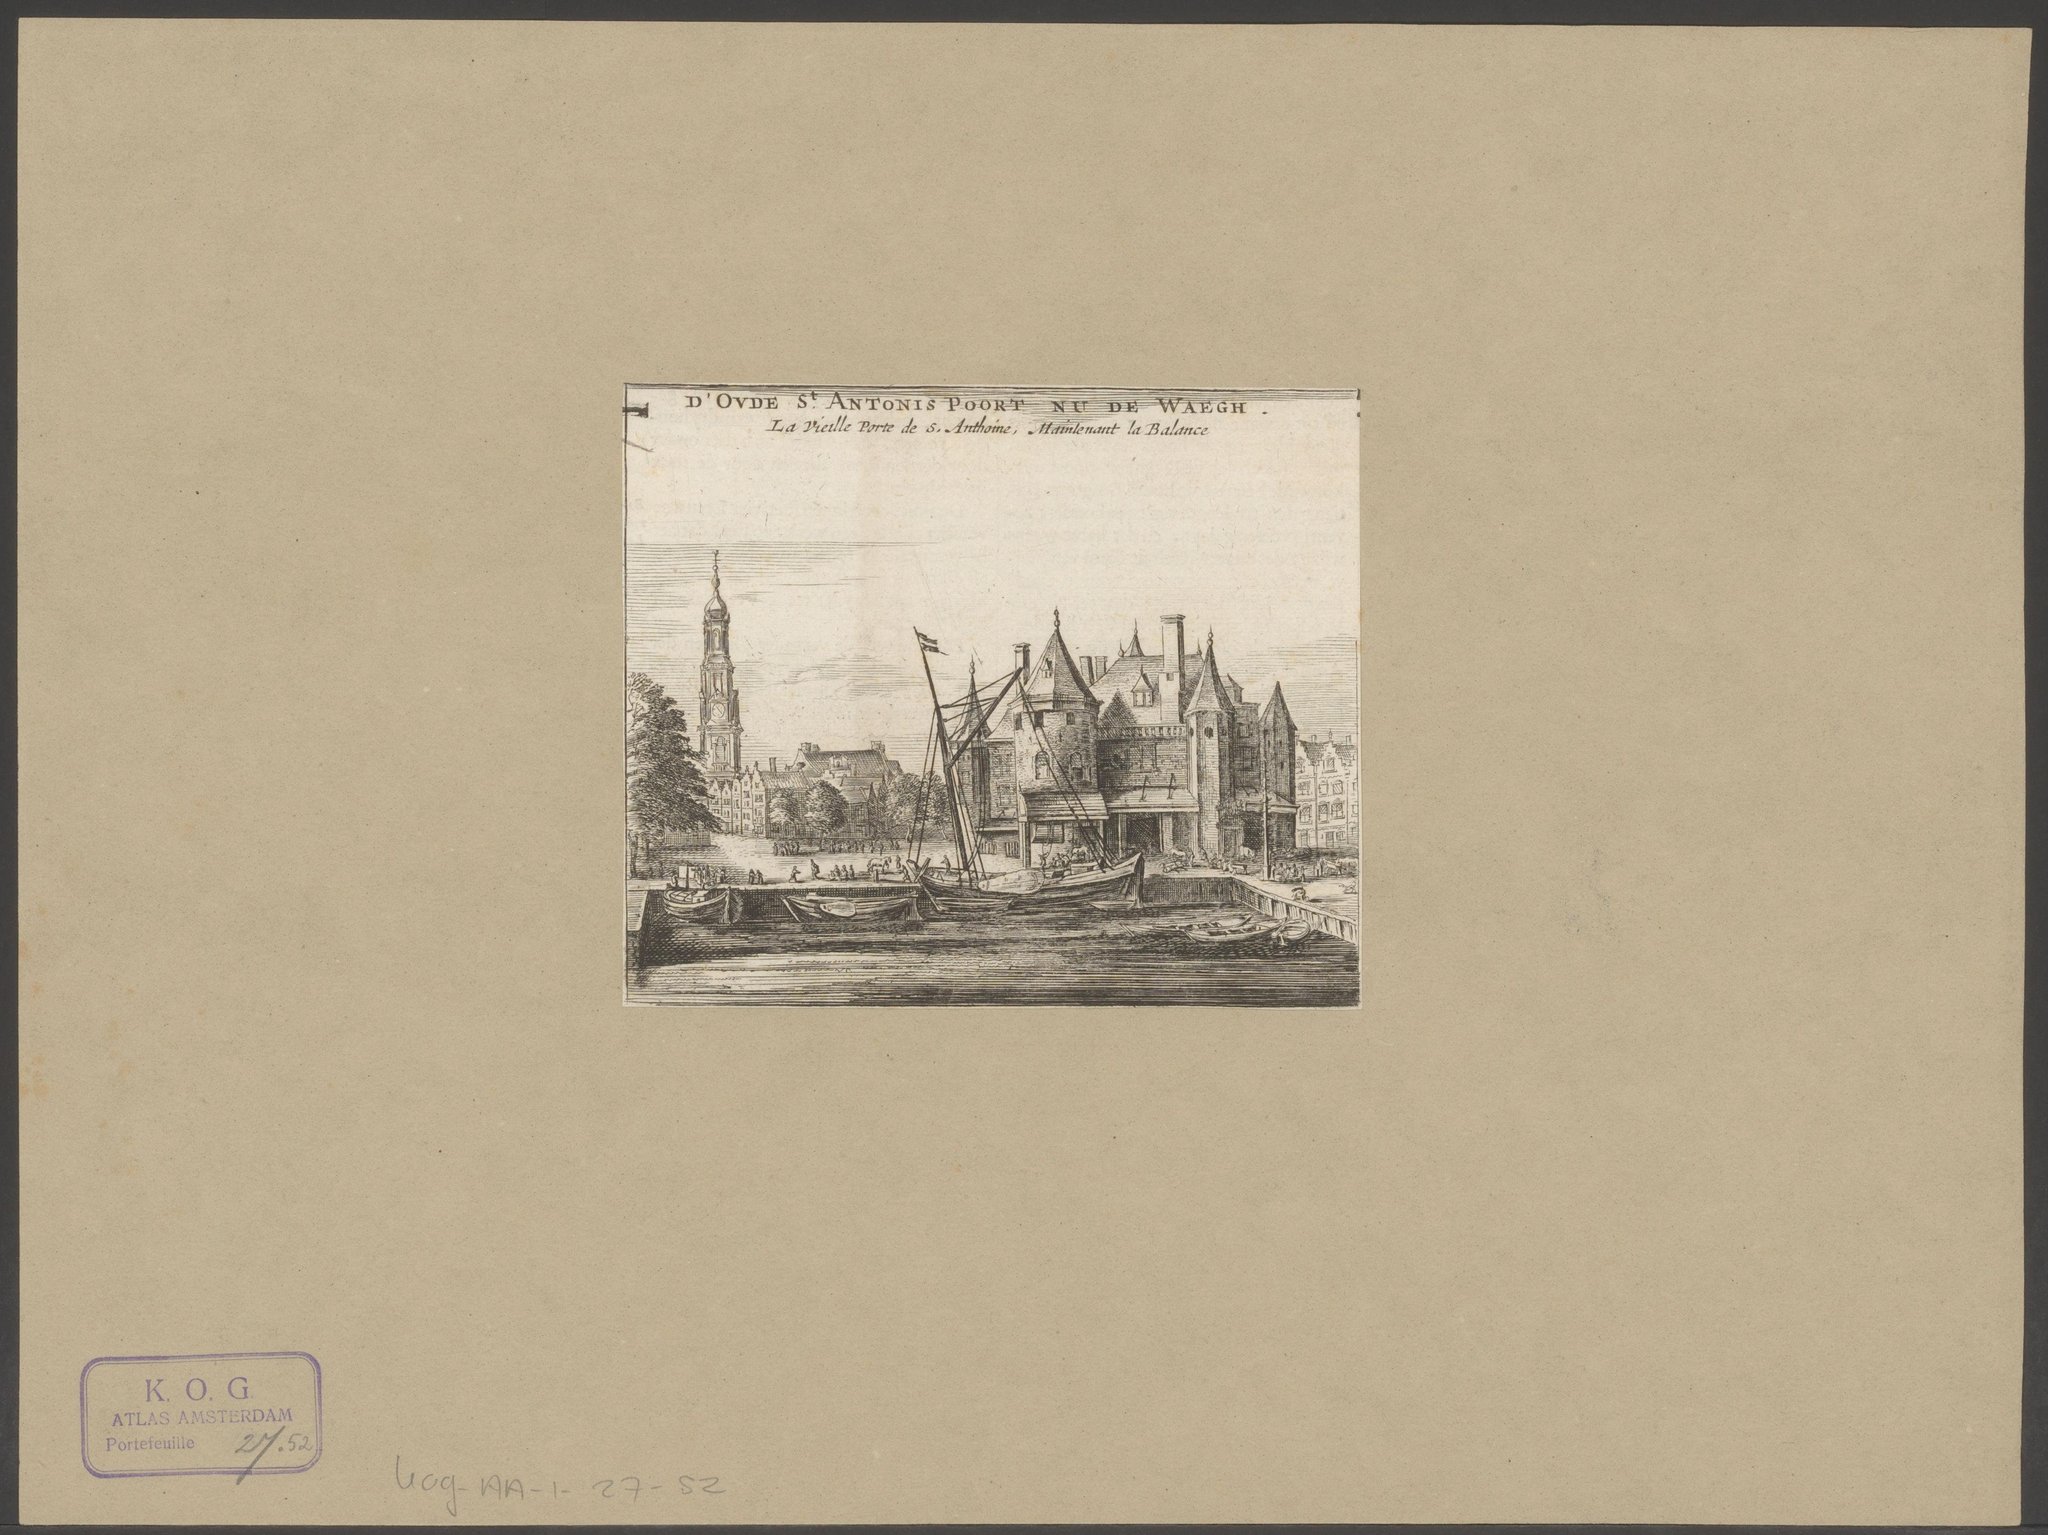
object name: print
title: D' Oude St Antonis Poort nu de Waegh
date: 1664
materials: paper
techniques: engraving, etching, letterpress printing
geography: amsterdam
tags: city-gate, weigh-house, canals, waters (in city) (+ city(-scape) with figures, staffage), parts of church exterior and annexes: tower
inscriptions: collector's mark: Lugt 1641b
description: Prent uit: Domselaer, Tobias en Isaac Commelin. Beschryvinge van Amsterdam: haar eerste oorspronk uyt den huyze der heeren van Aemstel en Aemstellant (…). 6 dln. Amsterdam: Marcus Willemsz van Doornick, 1665. Eerdere staat van prent ook gebruikt in: Fockens, Melchior. Beschrijving Der wijdt-vermaarde Koop-stadt Amstelredam, Van haar eerste beginselen, zedert den Jare 1203. oude Voorrechten, verscheyde Vergrootingenoude Voor-rechten, en verscheyde Vergrootingen (…). 3de druk. Amsterdam: Marcus Willemsz. Doornick, 1664. En in: Zesen, Philipp von. Beschrybung der Weidtberuhmde Kauf-Stadt Amstelredam / Beschreibung der Stadt Amsterdam darinnen von derselben ersten ursprunge bis auf gegenwartigen zustand (…). Amsterdam: Marcus Willemsz. Doornick, 1664. Derde bekende staat (rechtsboven genummerd: 40) ook gebruikt in verschillende latere zeventiende- en achttiende-eeuwse publicaties.